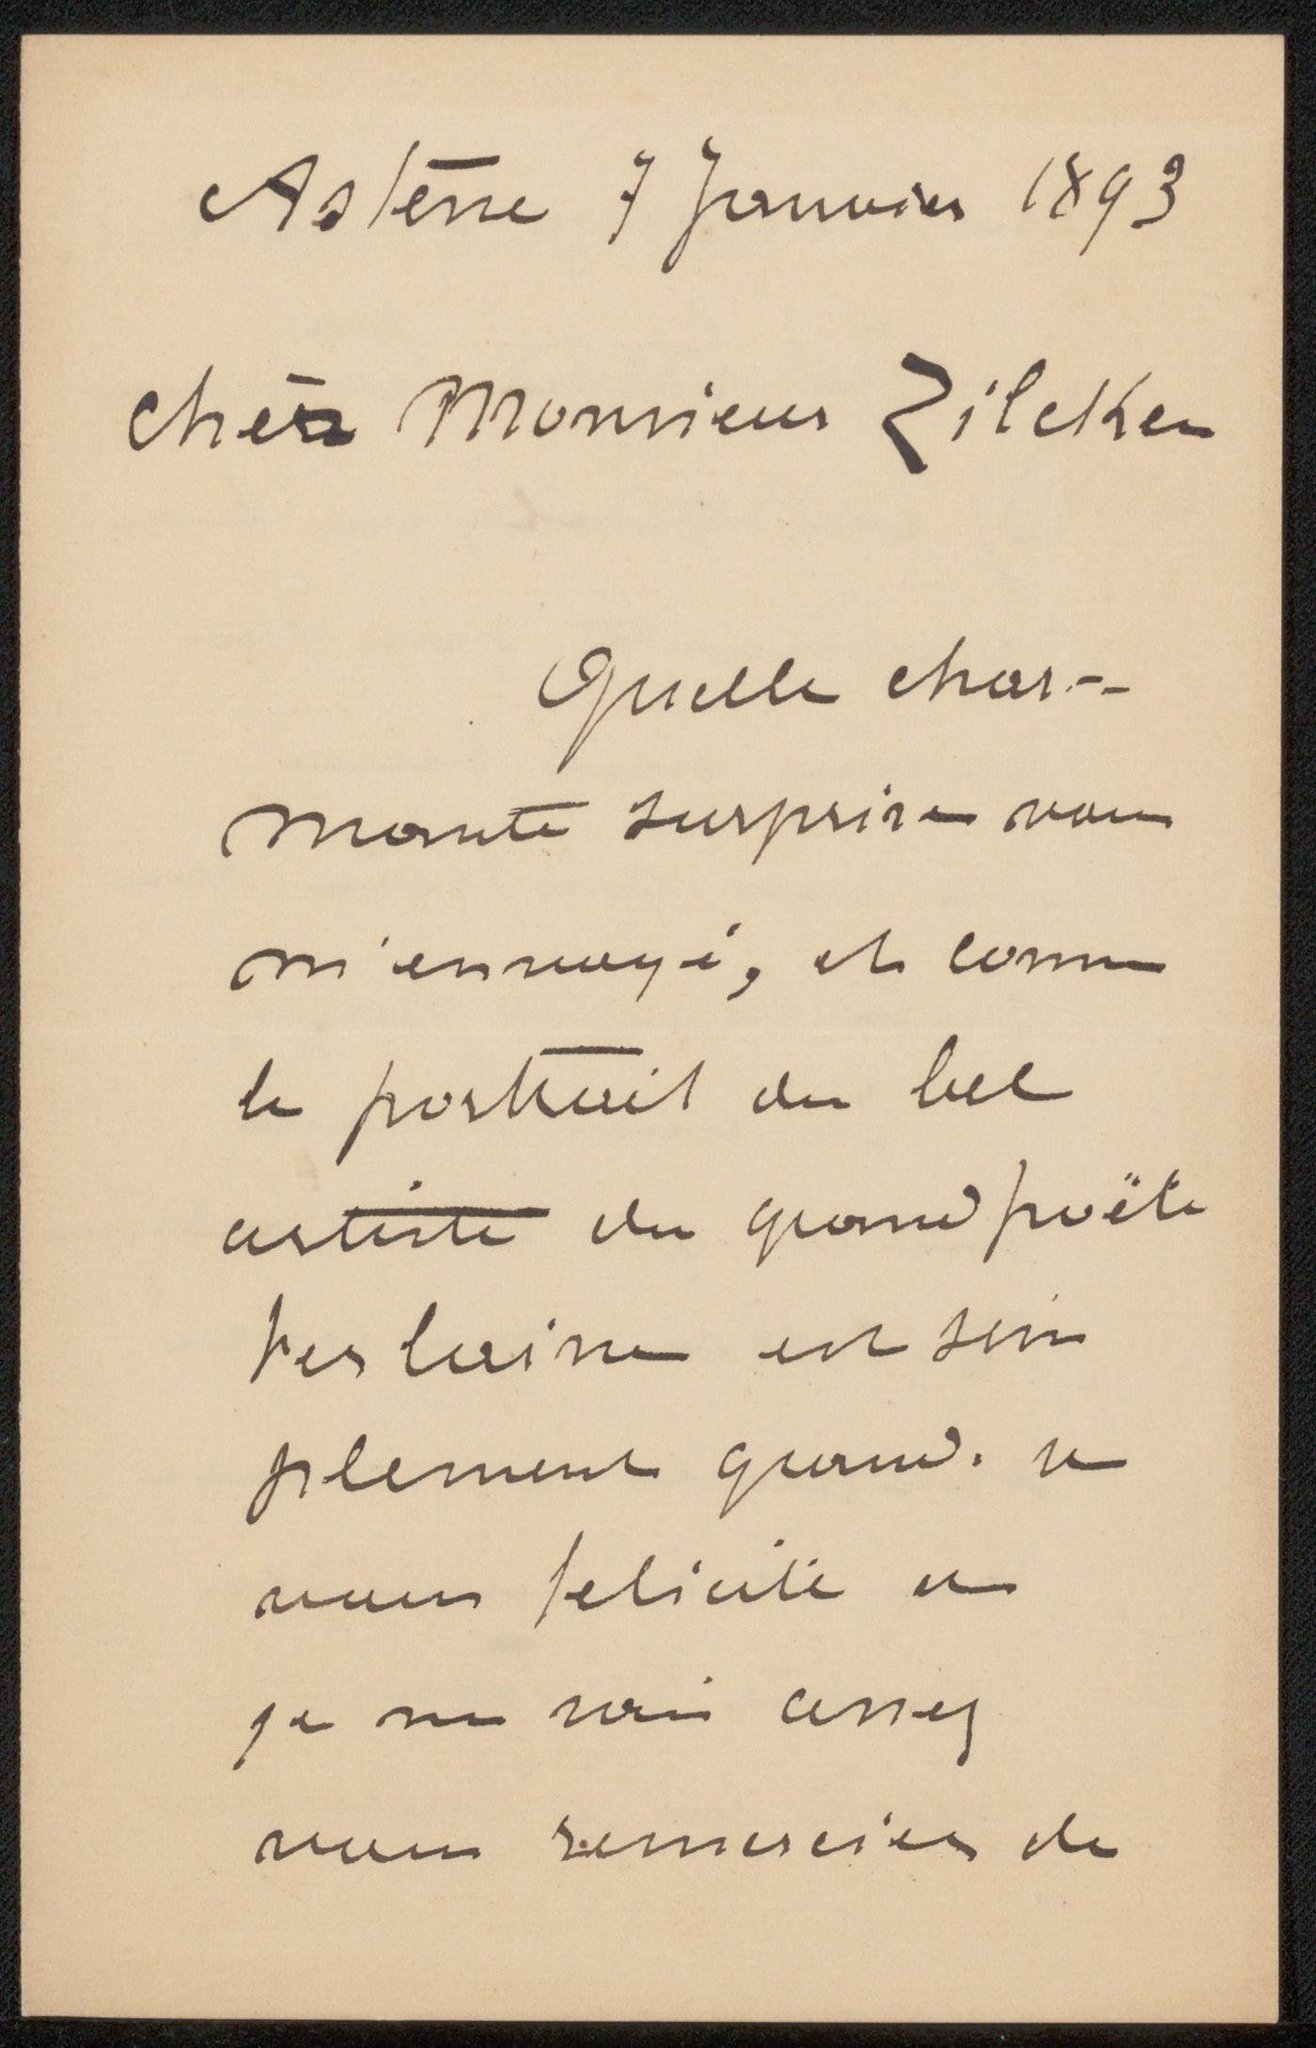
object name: letter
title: Brief aan Philip Zilcken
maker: emile claus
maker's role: print maker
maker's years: 1849-1924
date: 1893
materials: ink, paper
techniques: pen, writing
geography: astène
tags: painter, draughtsman, jan toorop, paris, paul verlaine, philip zilcken, historical persons (portraits and scenes from the life)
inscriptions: collector's mark: ‘RPK’